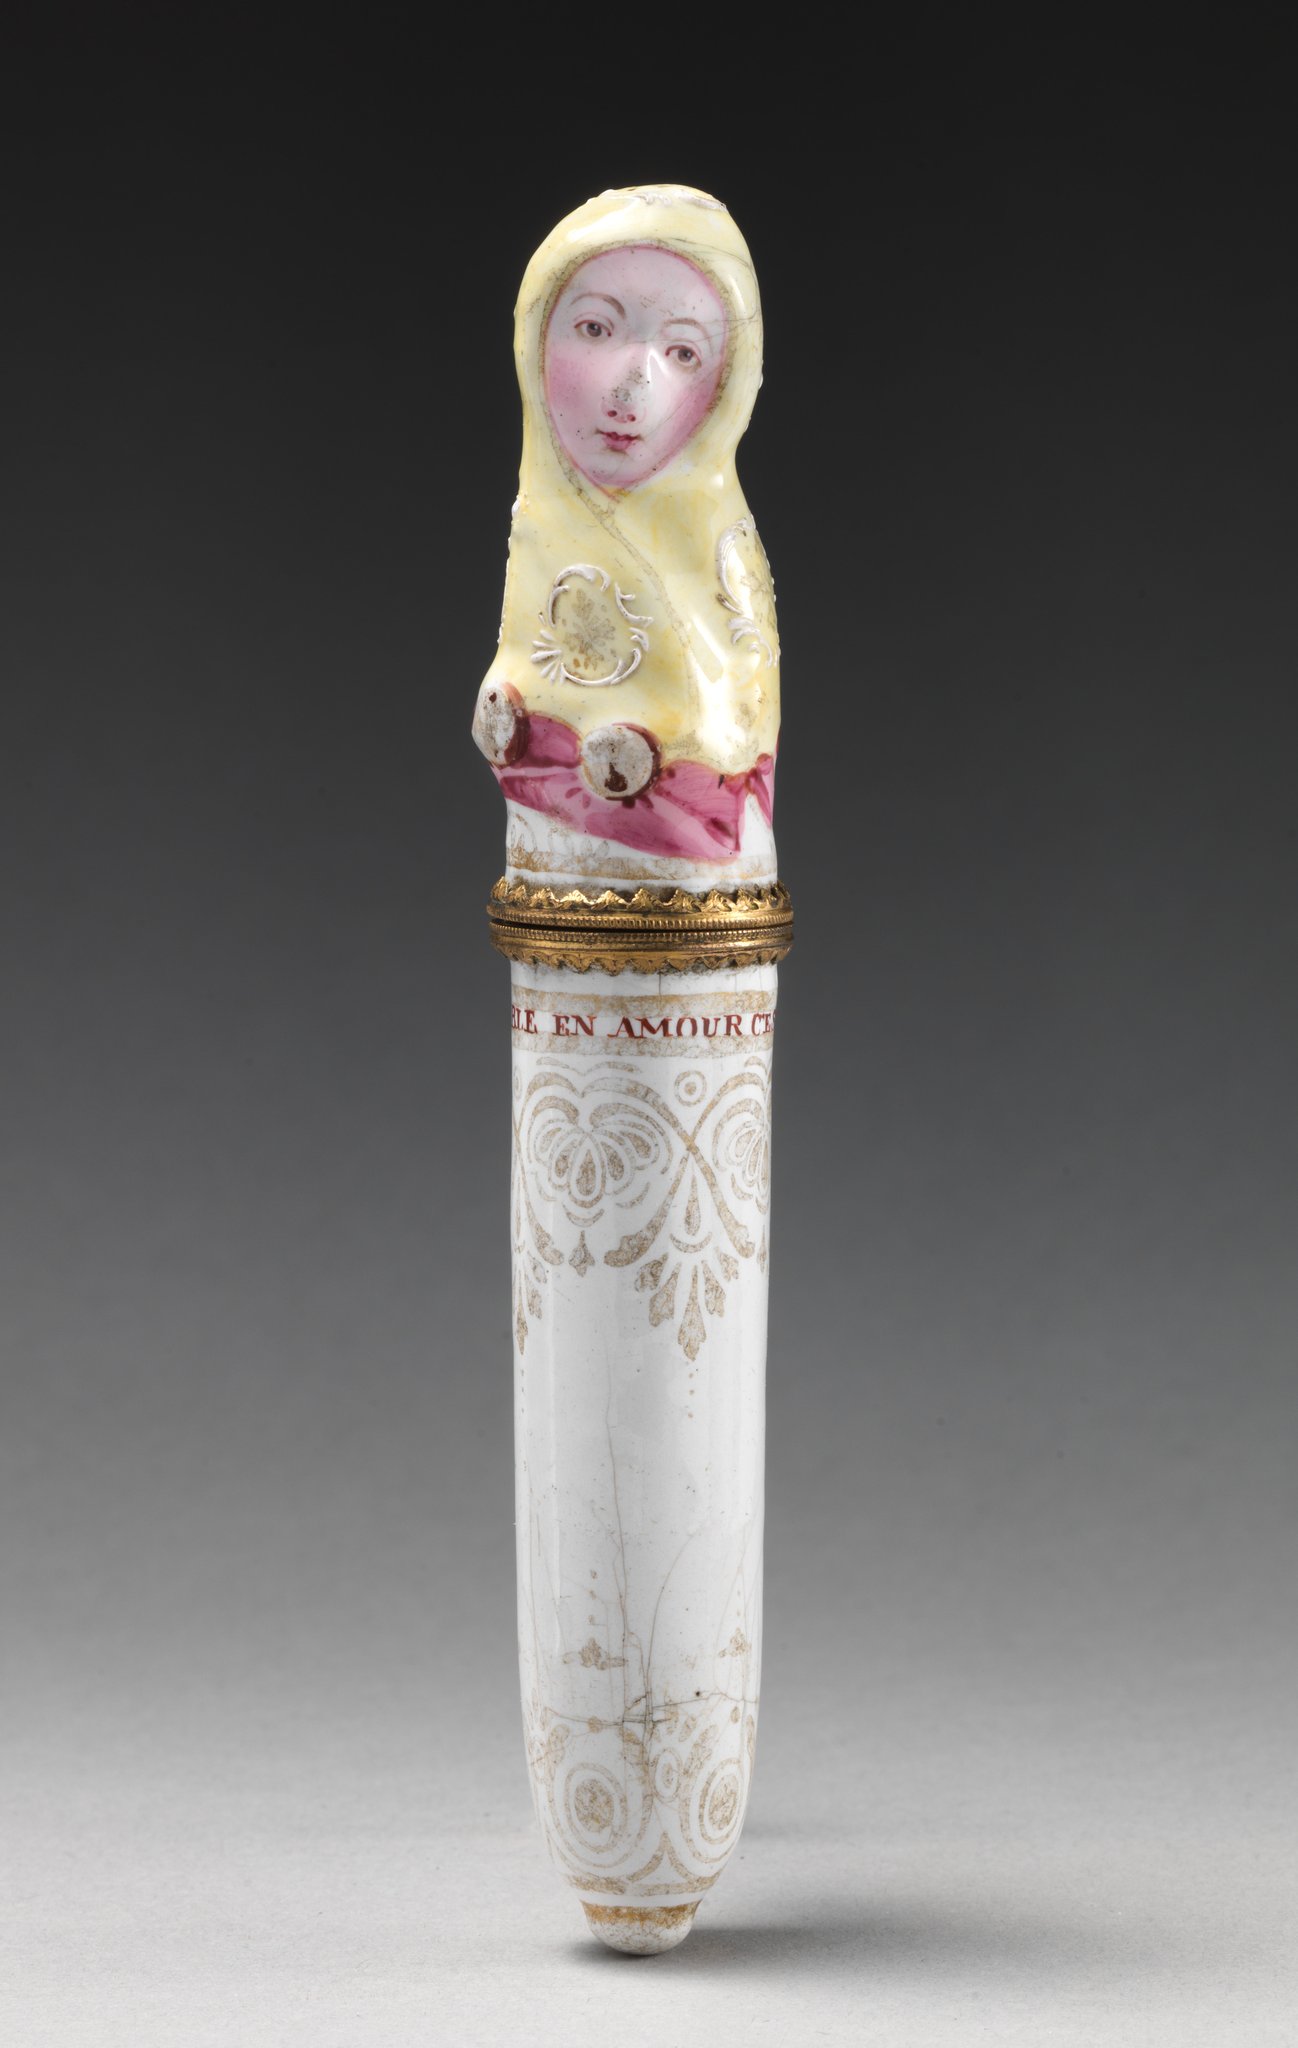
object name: bodkin case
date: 1770-1780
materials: copper, enamel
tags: faces,women